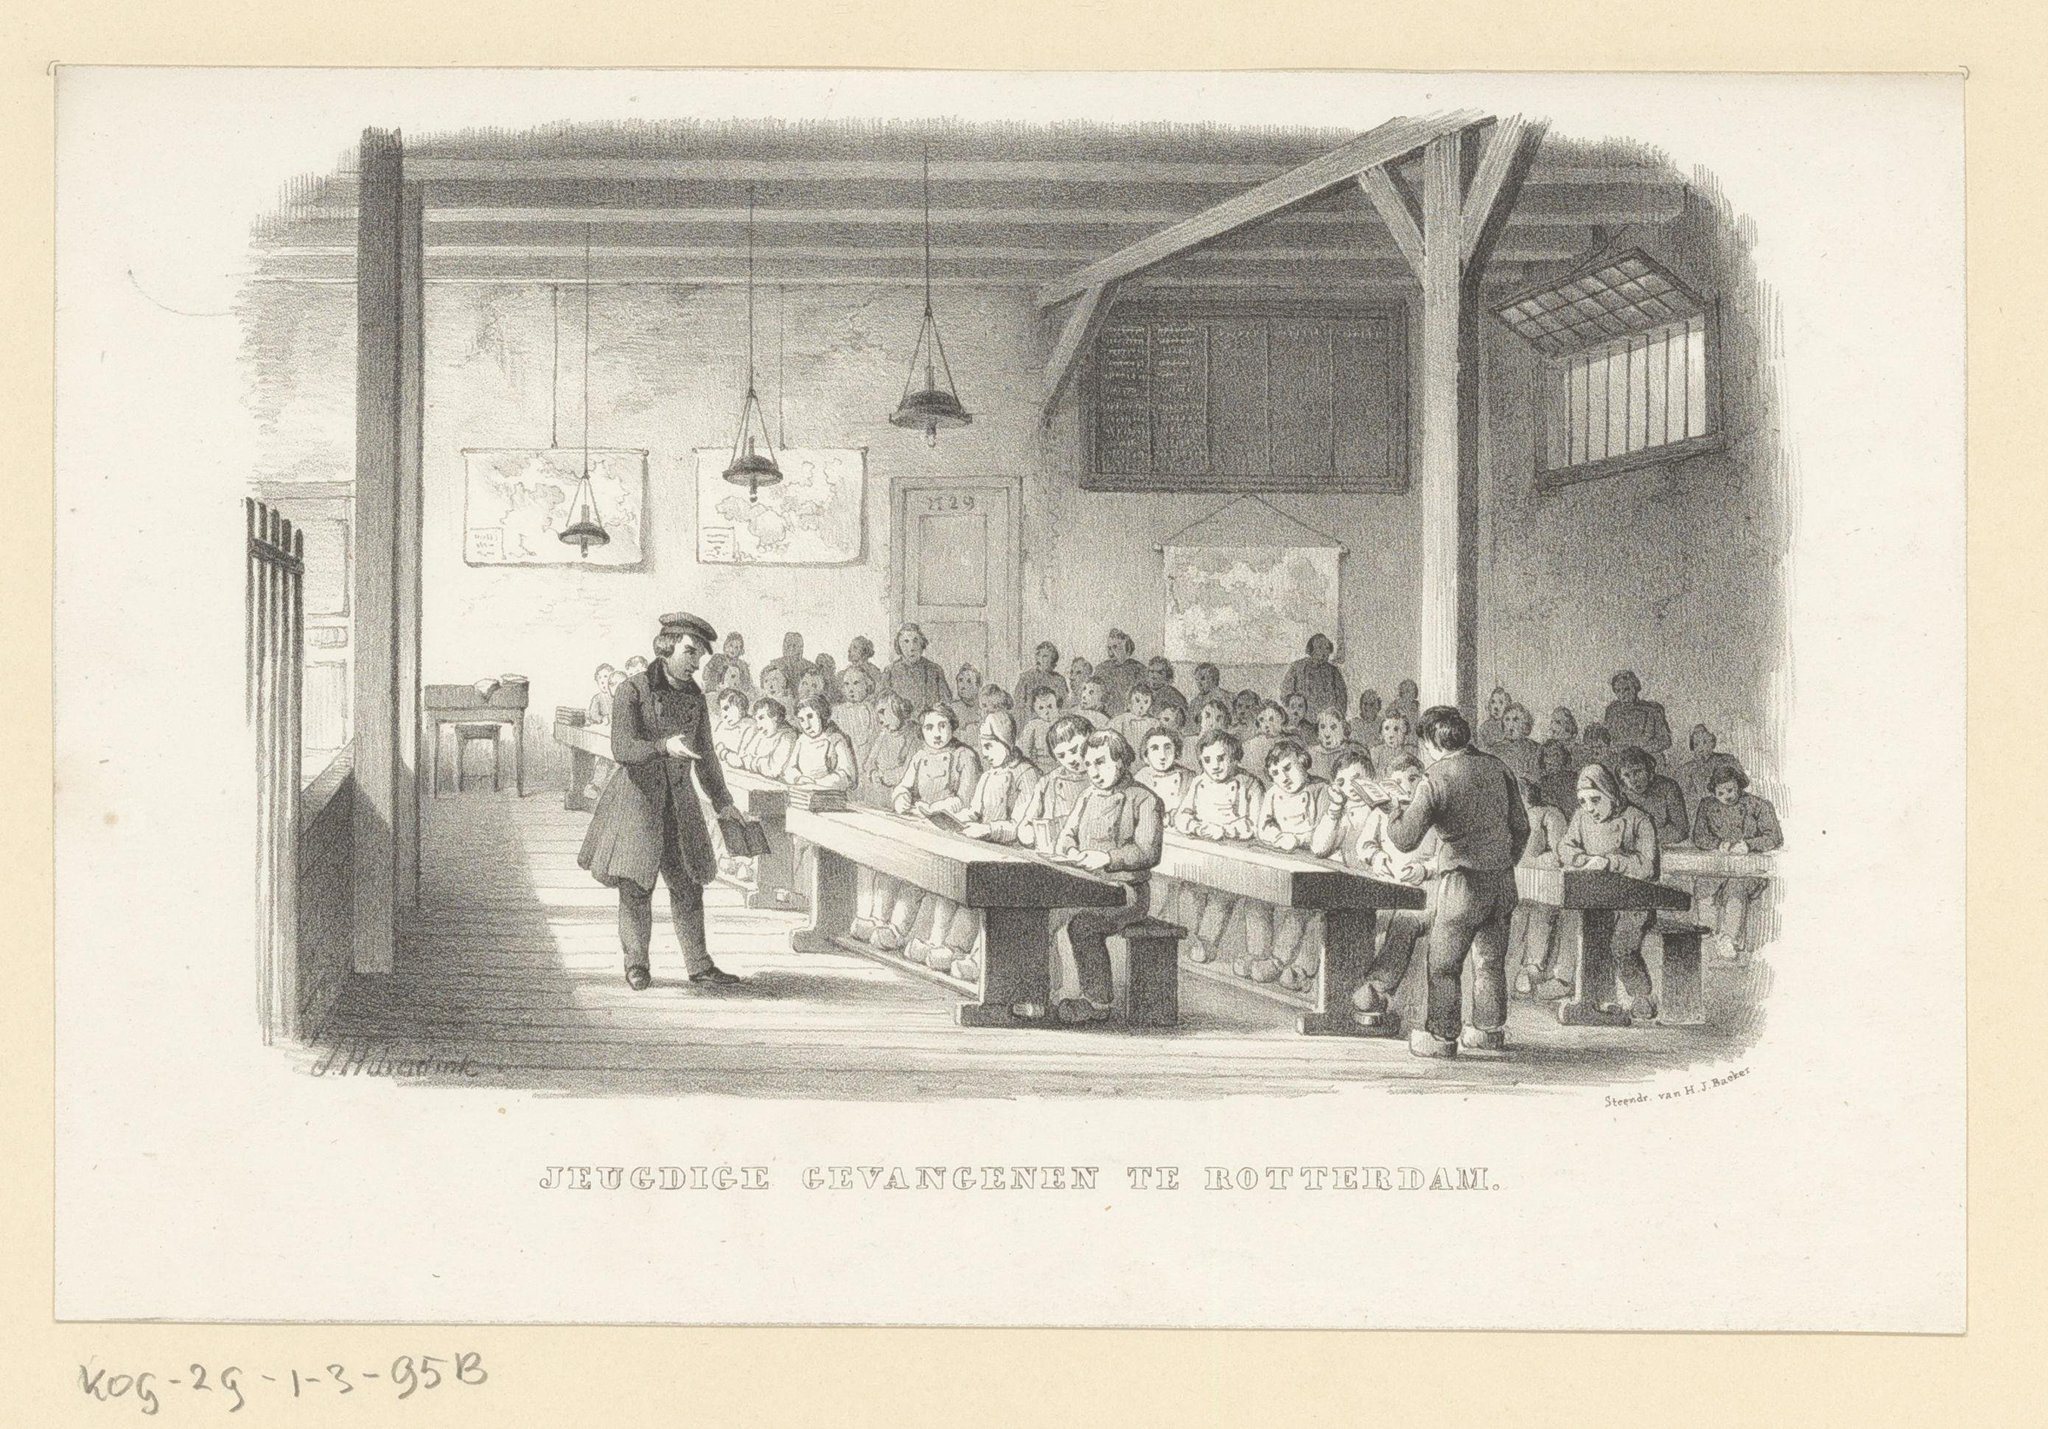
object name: print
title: Jonge gevangenen in een klaslokaal in Rotterdam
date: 1842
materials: paper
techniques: lithograph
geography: dordrecht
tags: prison, jail, workhouse, penal camp, penitentiary, chain gang, rotterdam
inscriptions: collector's mark: Lugt 1641, stamp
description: Prent mogelijk uit: Nederlanders door Nederlanders geschetst. Amsterdam: J.H. Laarman, 1842.